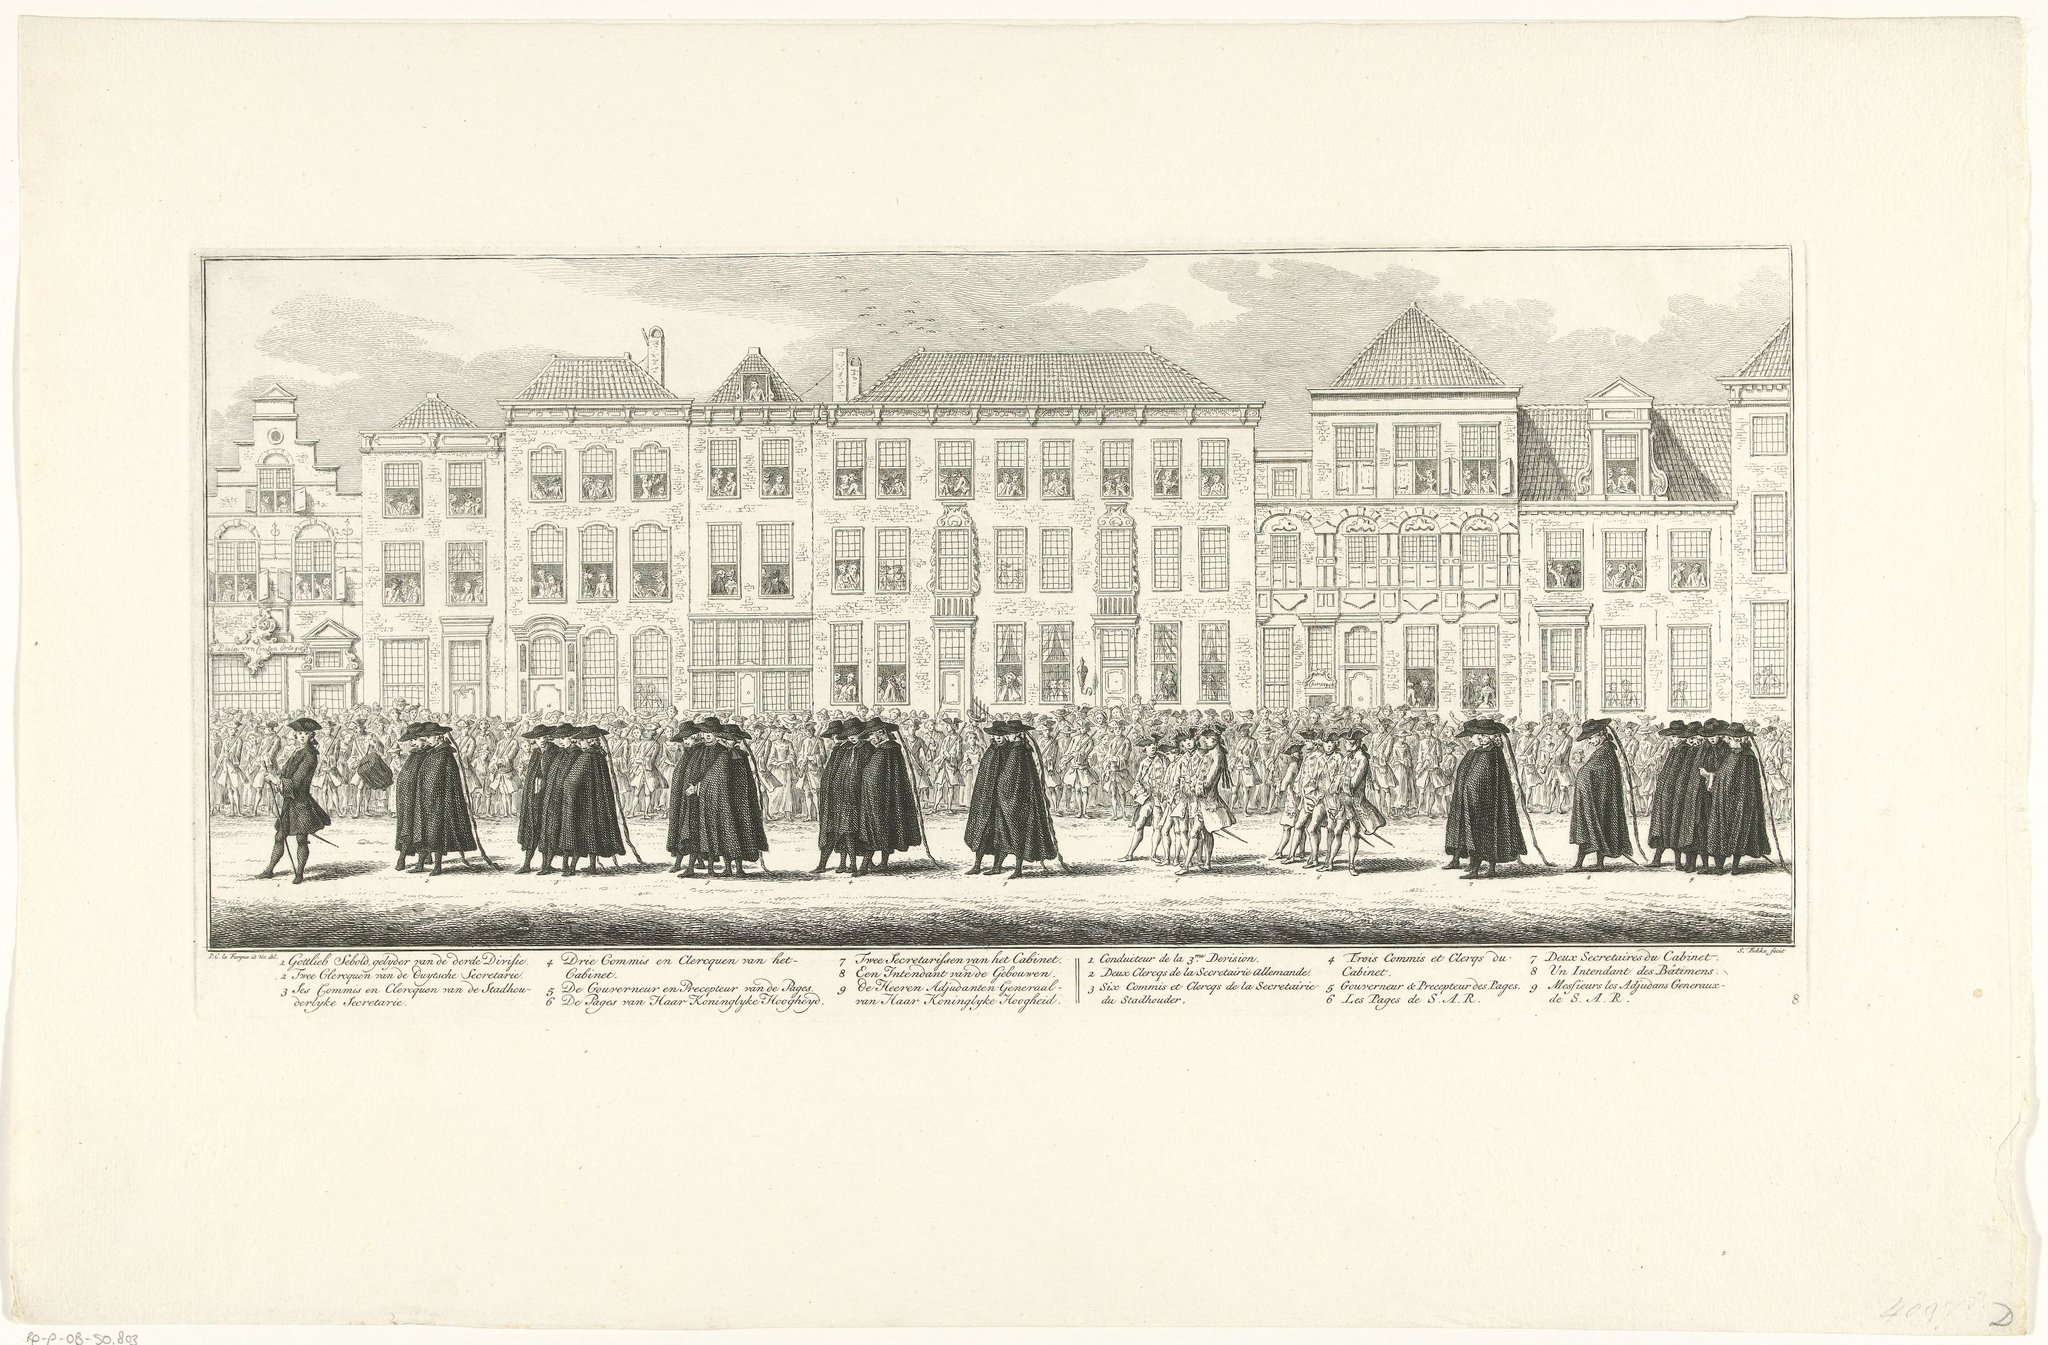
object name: print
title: Leden van de hoffelijke administratie in de lijkstoet van Anna van Hannover te Delft, 1759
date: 1759-1761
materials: paper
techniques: etching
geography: amsterdam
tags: anna van hannover, cortege, funeral procession, delft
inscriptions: collector's mark: Lugt 2228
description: Leden van de hoffelijke administratie te voet in de lijkstoet van Anna van Hannover, prinses van Oranje-Nassau, te Delft. De figuren in de stoet zijn genummerd en onder de voorstelling nader omschreven.